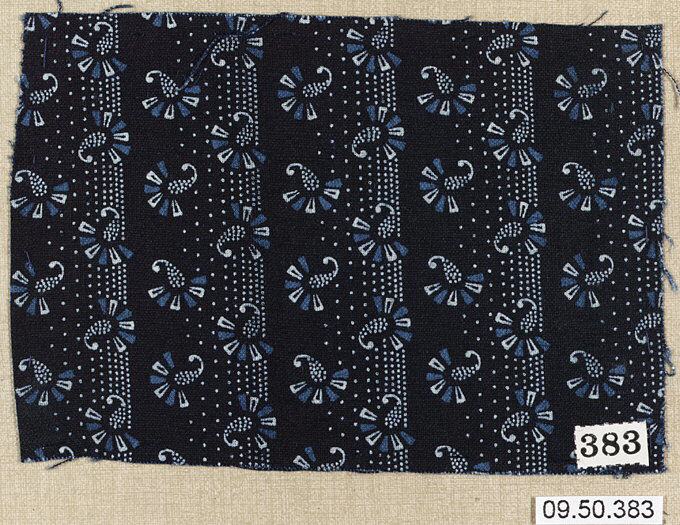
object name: piece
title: Piece (one of 116)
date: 1801-1900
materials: cotton